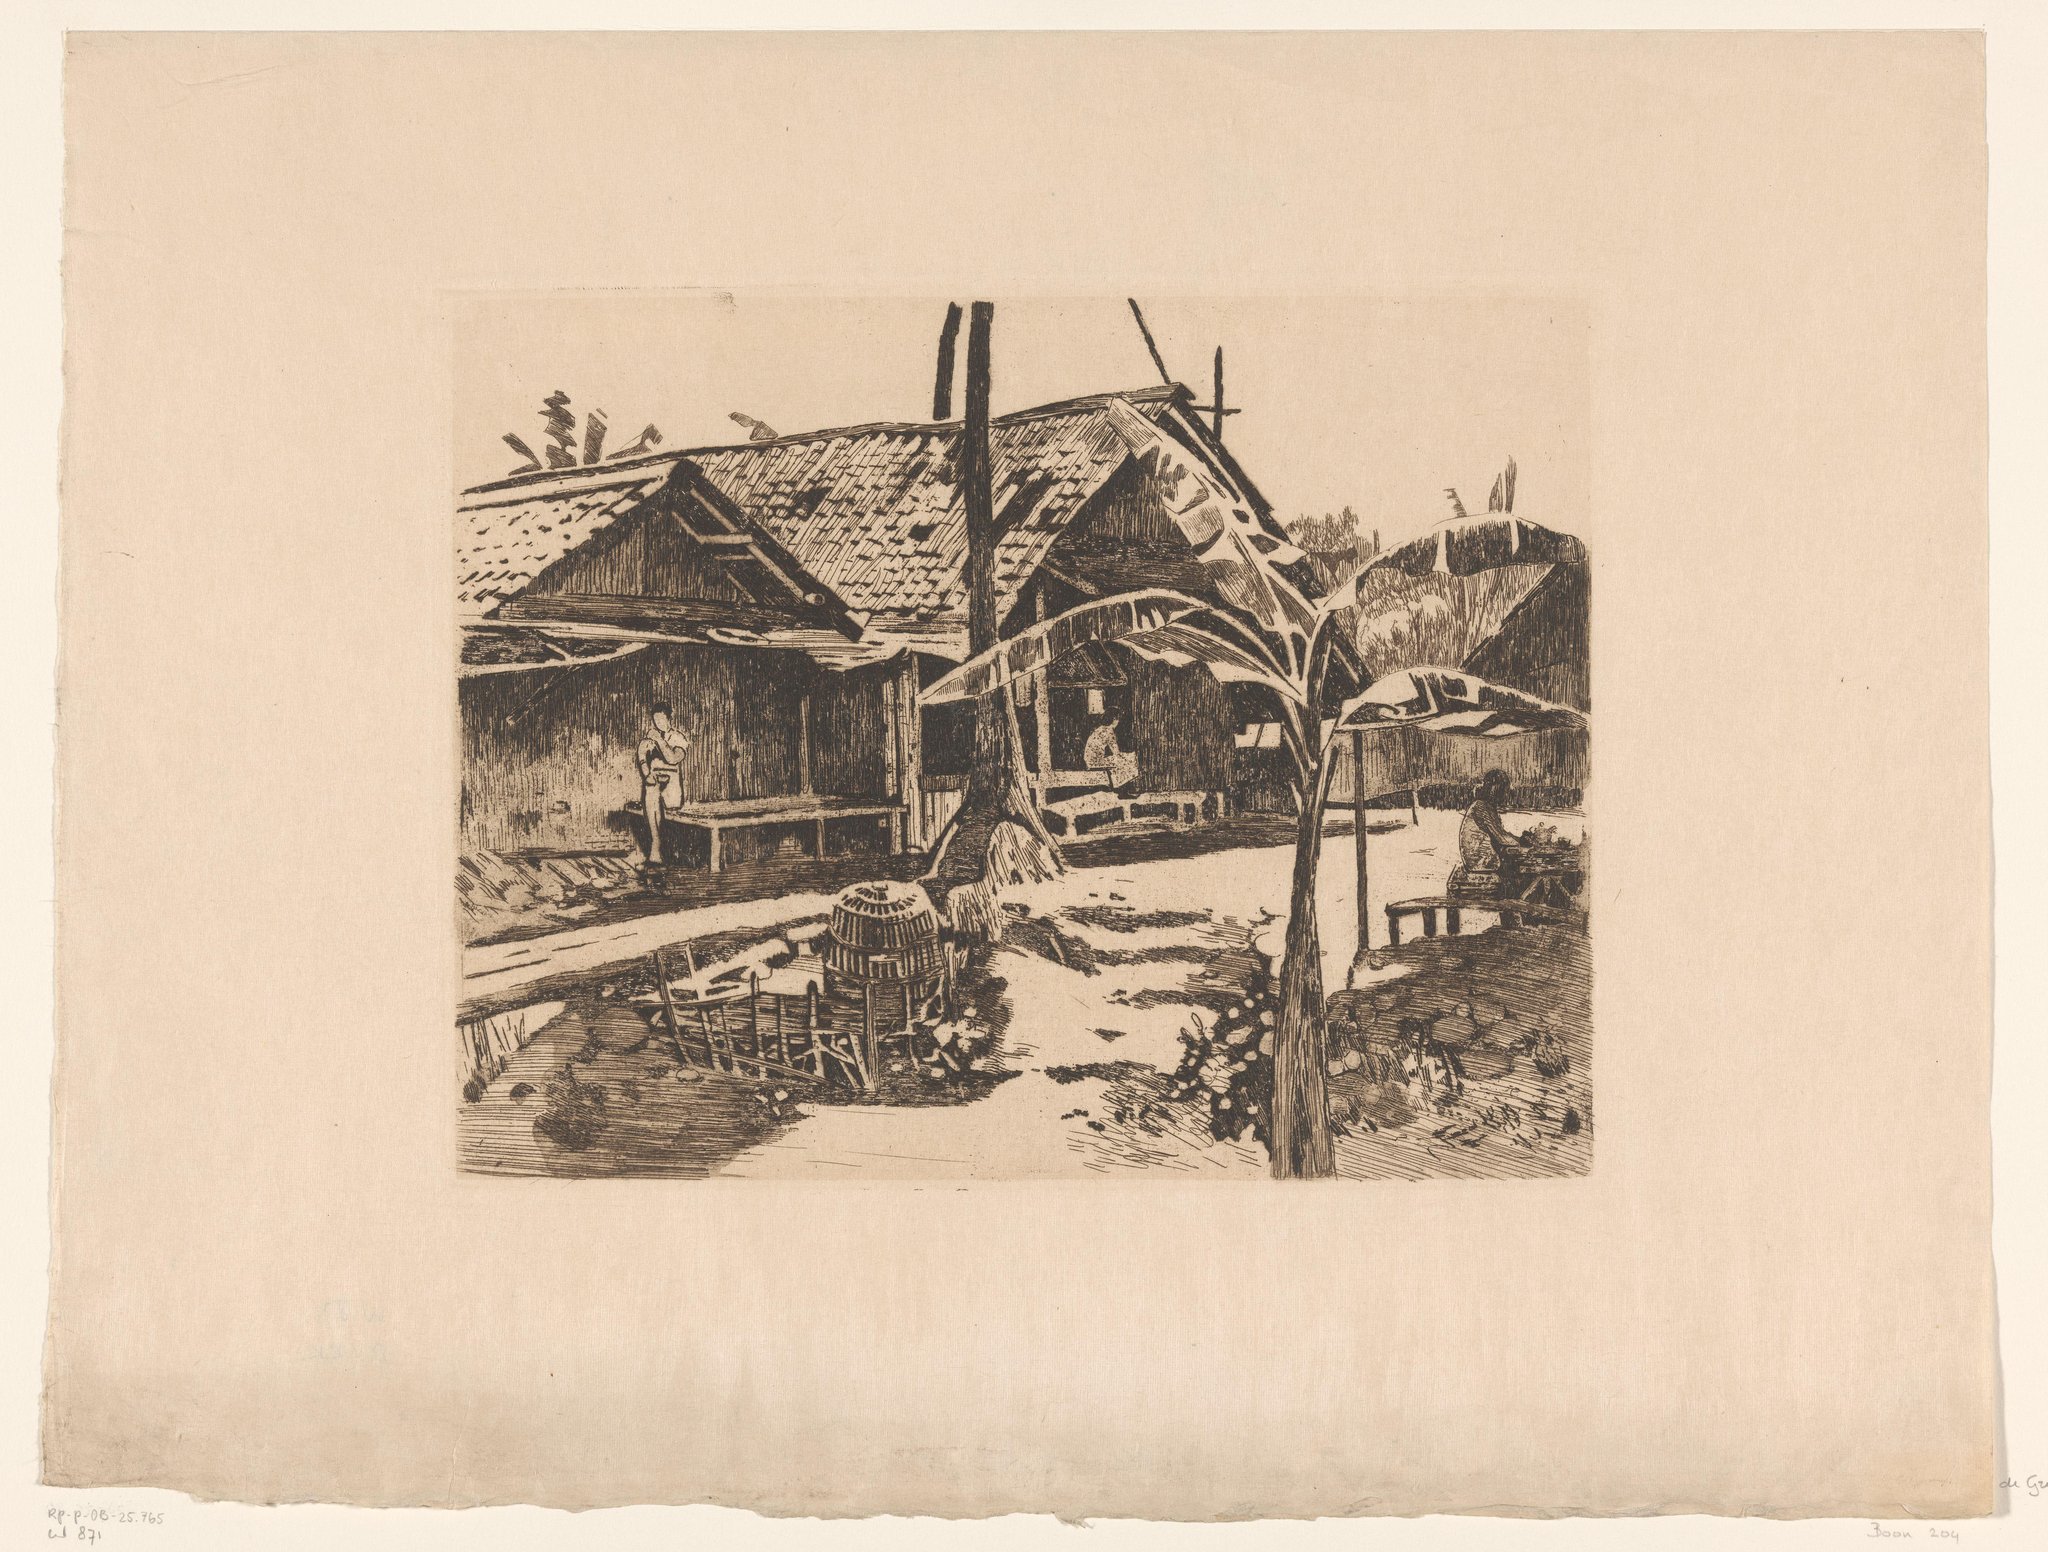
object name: print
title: Pisangboom in een kampong in Buitenzorg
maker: willem witsen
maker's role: draughtsman, painter, print maker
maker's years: 1860-1923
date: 1921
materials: paper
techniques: aquatint, etching, intaglio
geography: amsterdam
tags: trees, sitting figure, village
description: Links, midden en rechts zijn drie zittende figuren afgebeeld.